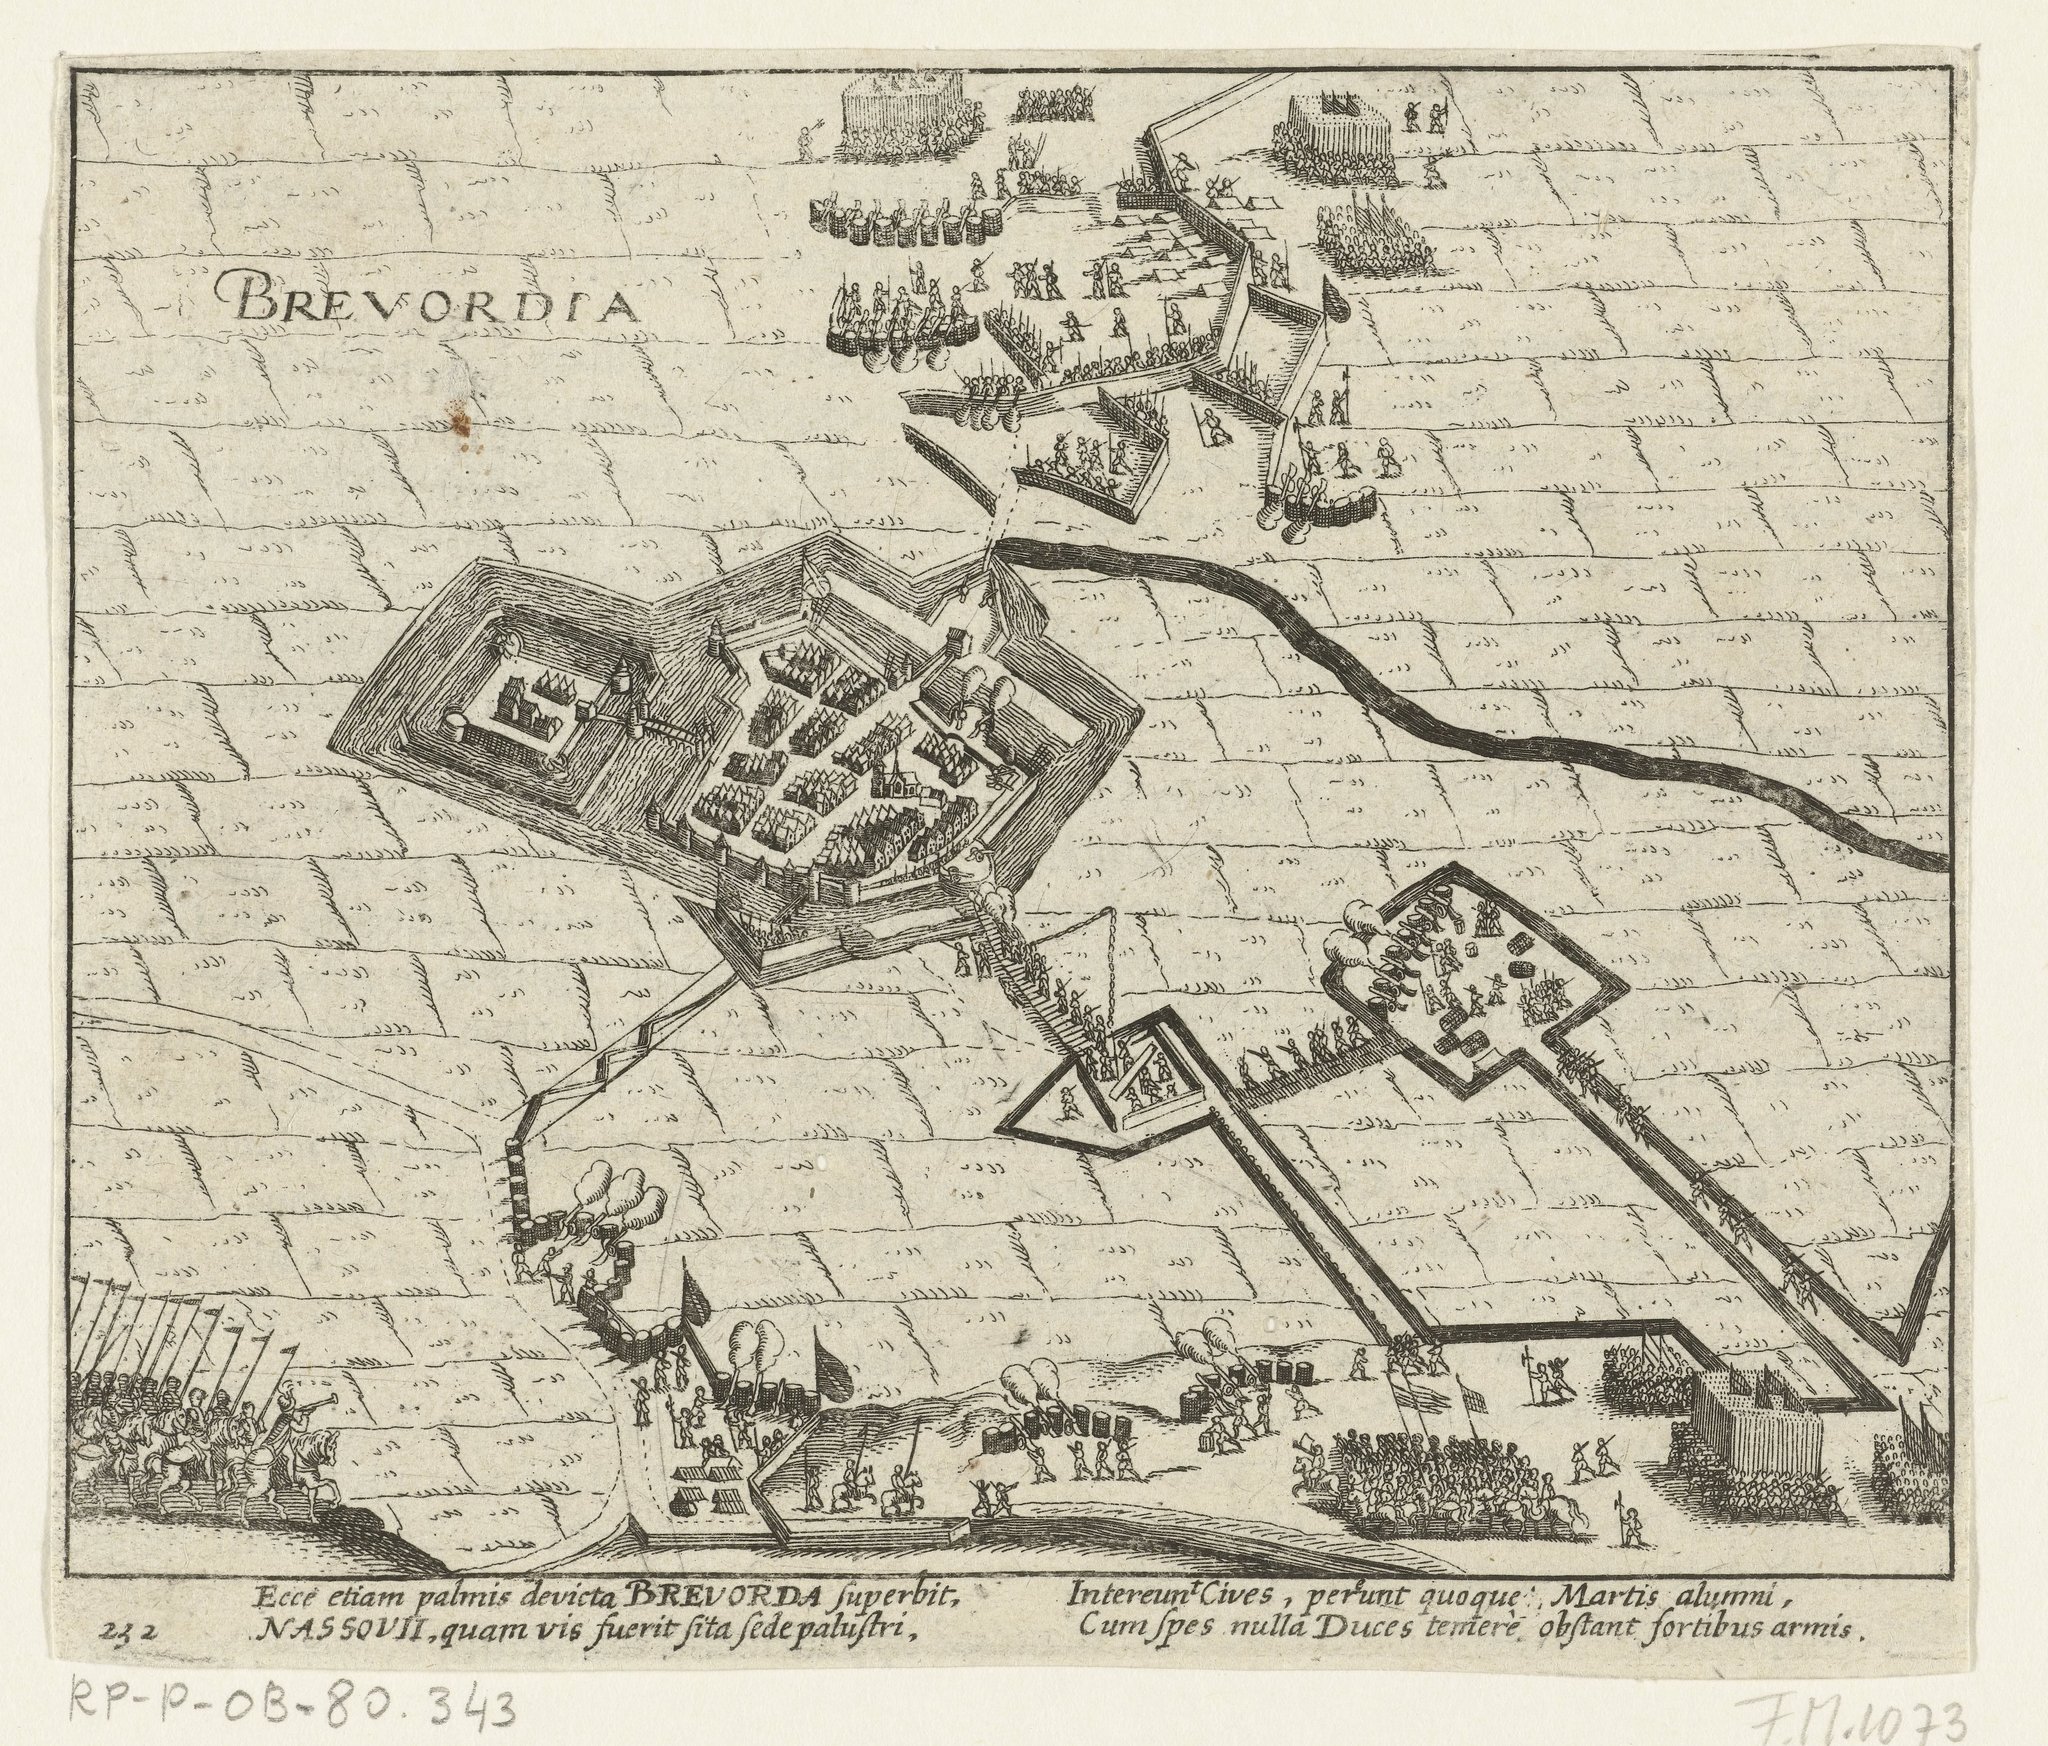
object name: print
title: Beleg en verovering van Bredevoort, 1597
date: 1613-1615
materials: paper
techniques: etching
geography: northern netherlands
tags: the hague, maurice (prince of orange), siege, position war, capture of city (after the siege)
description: Beleg en verovering van de plaats en het kasteel van Bredevoort, door het Staatse leger onder prins Maurits, 12 oktober 1597. Plan van de stad met de posities van het belgerende Staatse leger. Met onderschrift van vier regels in het Latijn. Genummerd 232. Bedrukt op de achterzijde met tekst in het Latijn.